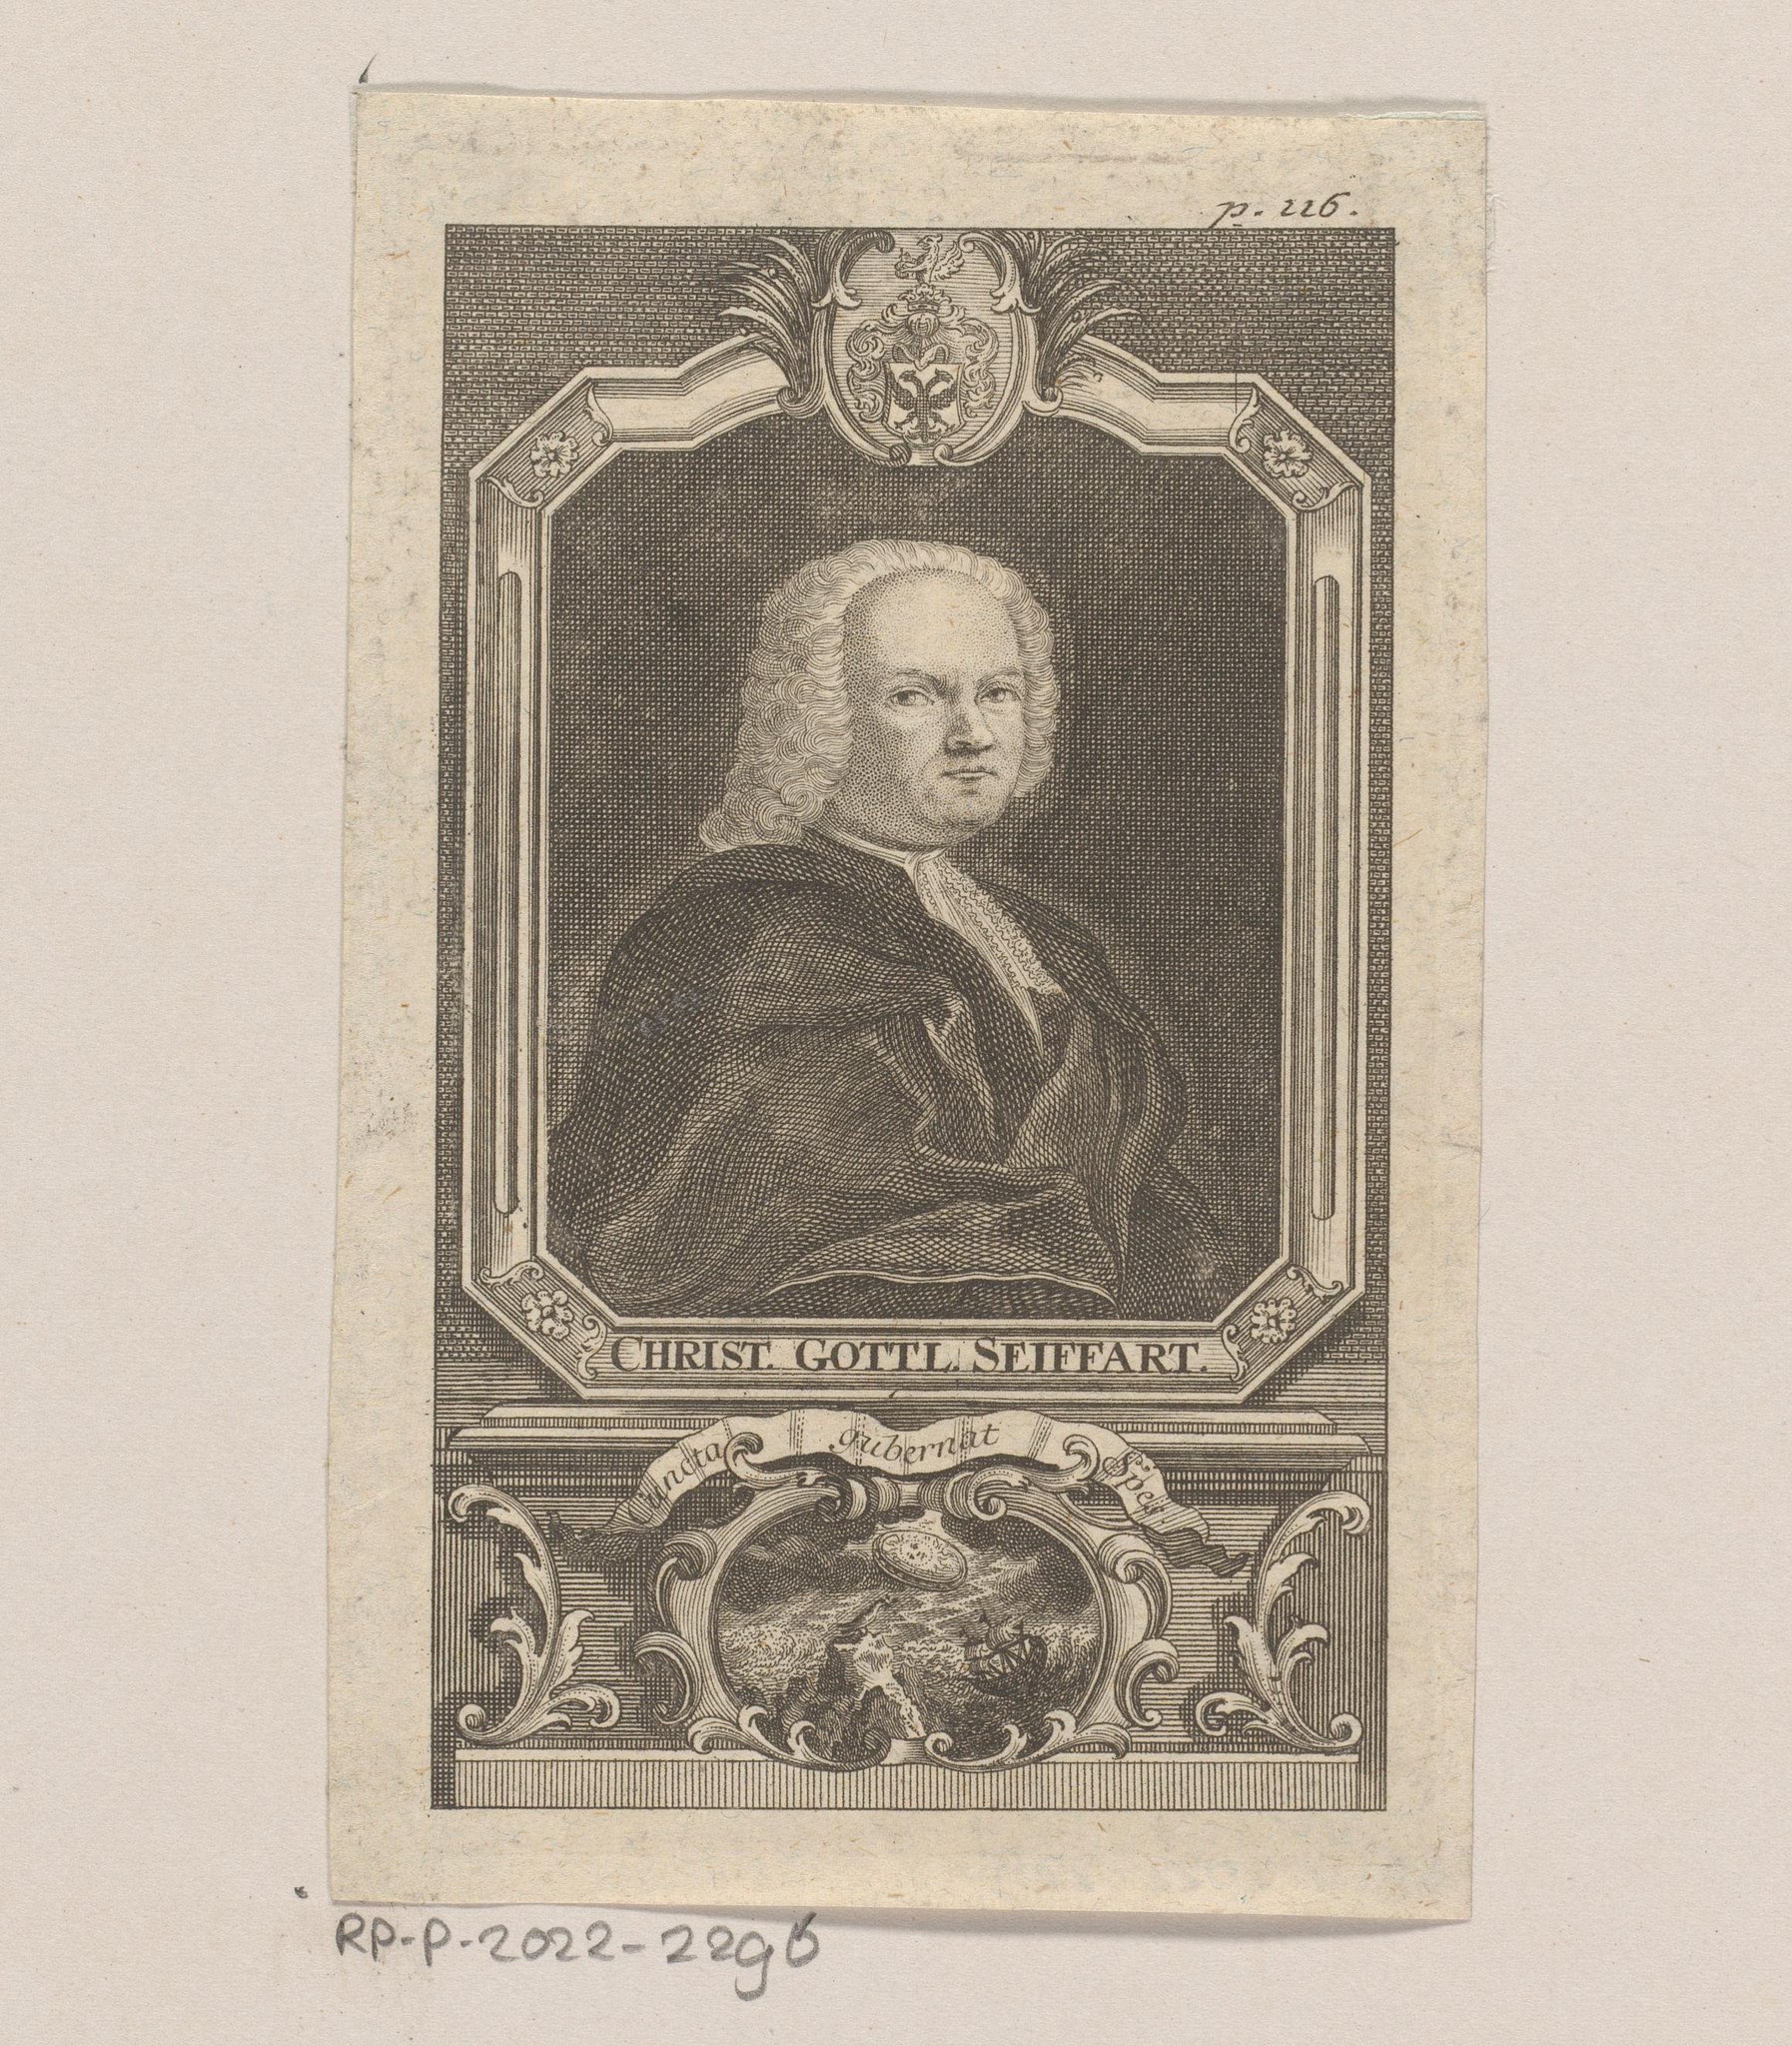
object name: print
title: Portret van Christian Gottlieb Seiffart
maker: Anonymous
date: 1740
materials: paper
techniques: engraving, etching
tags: historical persons, publishing, publisher, book-shop, bookseller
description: Prent waarschijnlijk uit: Der so nöthig als nützliche Buchdruckerkunst und Schriftgiesserey. Leipzig: Christian Friedrich Gessner, 1740, dl. 2.